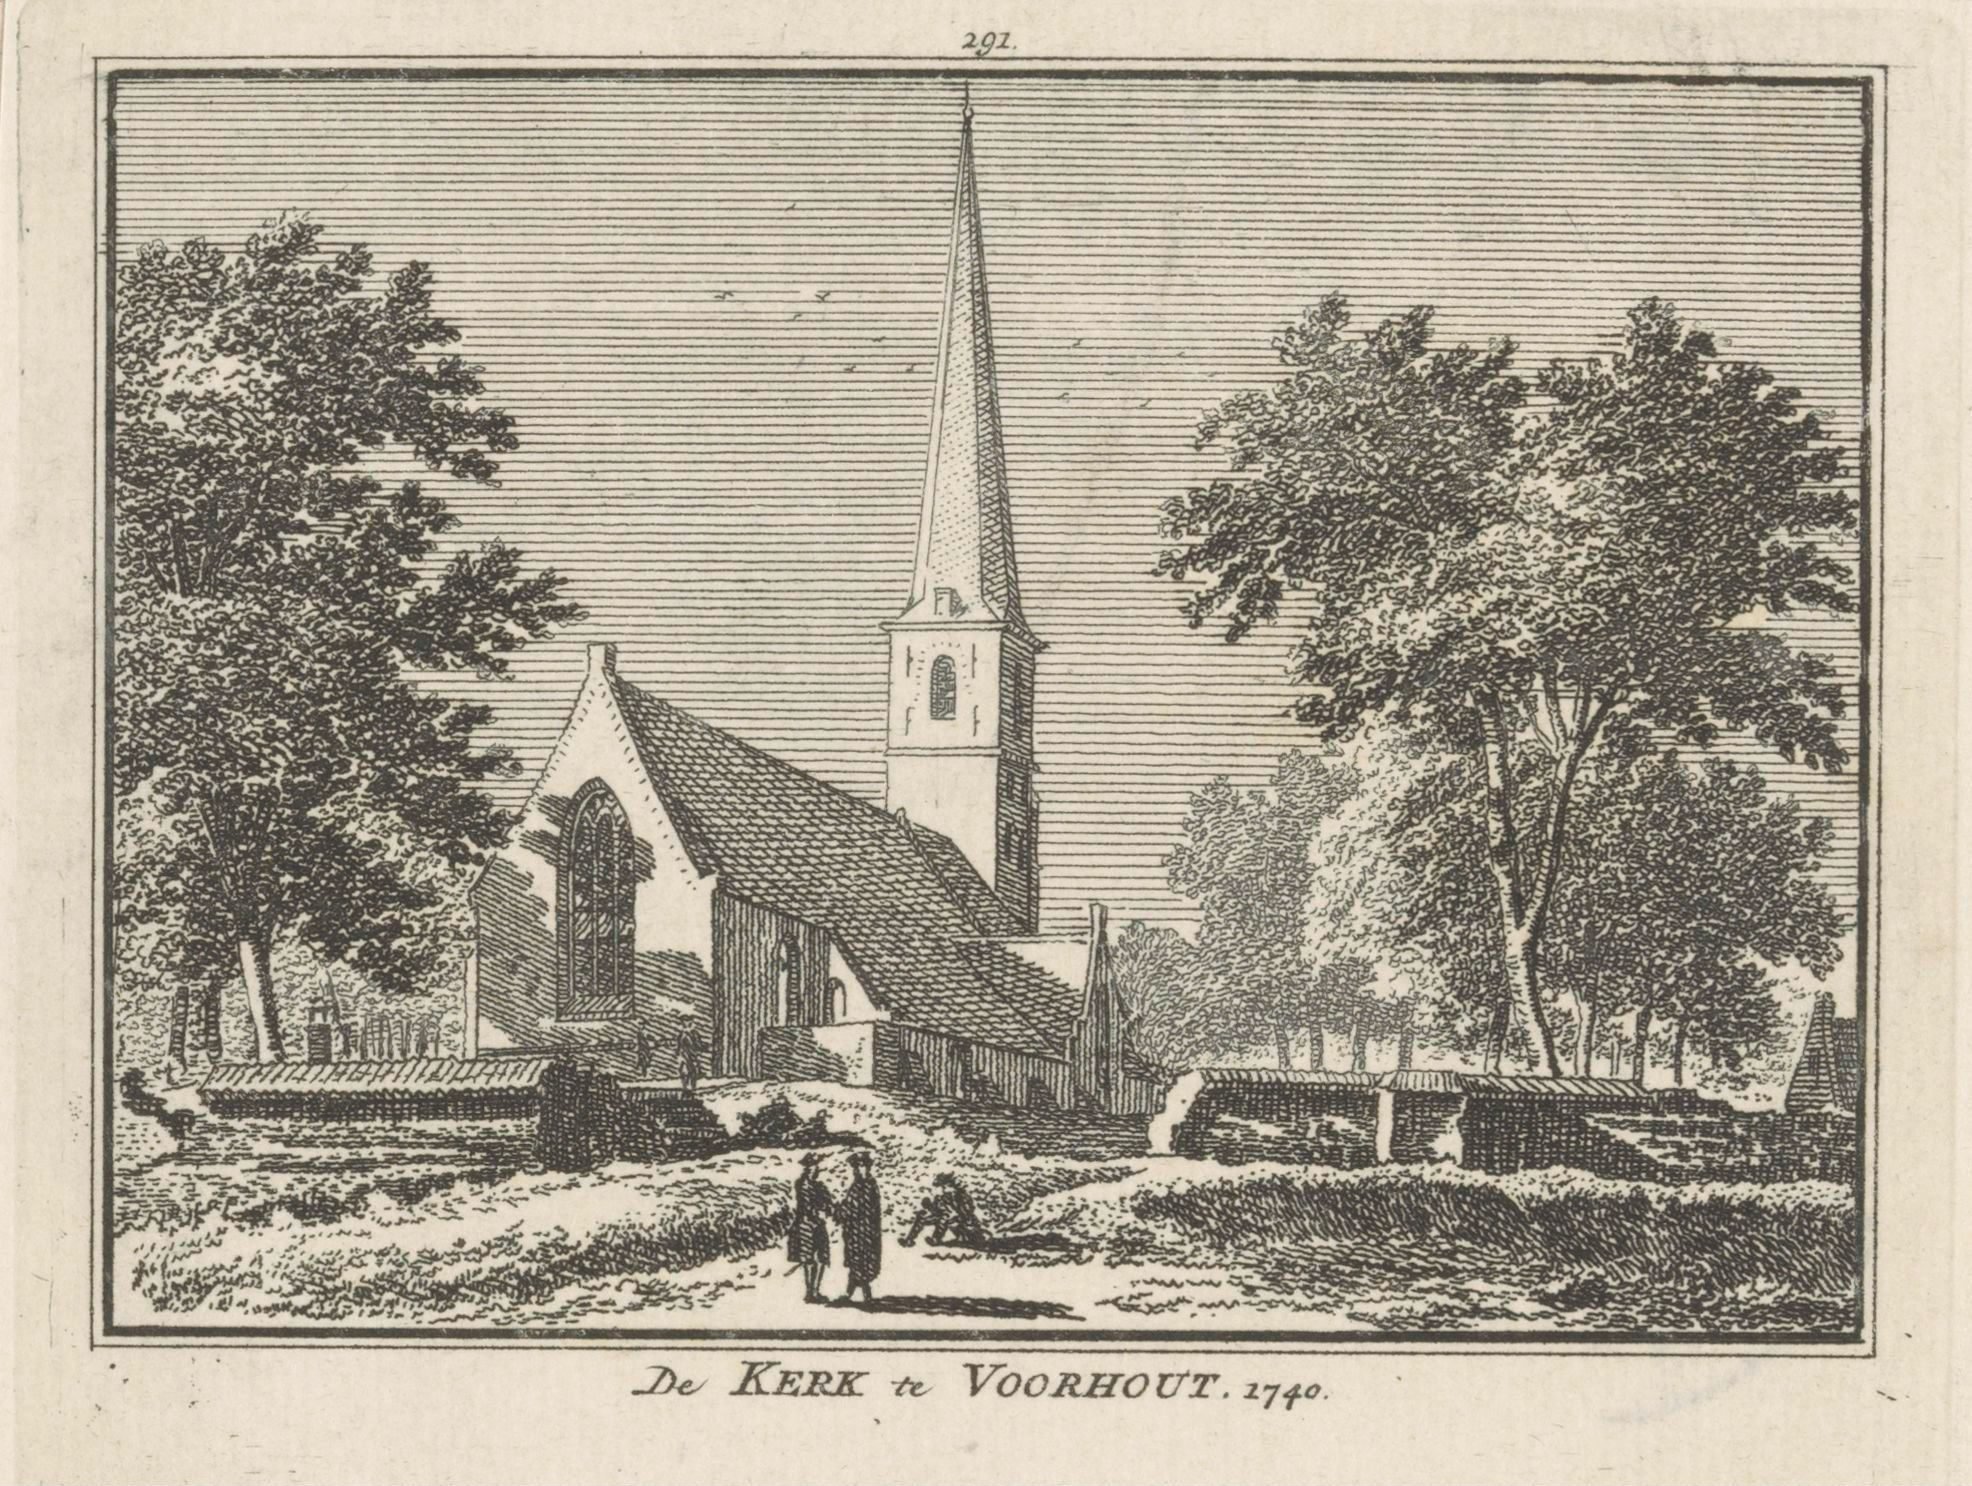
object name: print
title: De kerk te Voorhout. 1740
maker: hendrik spilman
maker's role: draughtsman, painter, print maker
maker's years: 1721-1784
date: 1750-1792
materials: paper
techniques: engraving, etching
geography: haarlem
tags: church (exterior)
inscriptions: collector's mark: Lugt 2228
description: Prent ook gebruikt in: Het verheerlykt Nederland of kabinet van hedendaagsche gezigten van steden, dorpen (…). 9 delen. Amsterdam: Isaak Tirion en weduwe Isaak Tirion, 1745-1774, dl. 3 (1750), ill. 291. Of in: Nederlandsche tafereelen; of eene keurige verzameling van negen honderd fraaije gezigten van steden, dorpen, sloten, oudheden (….). 9 delen. Amsterdam: Jan de Groot, 1792, dl. 3, ill. 291.